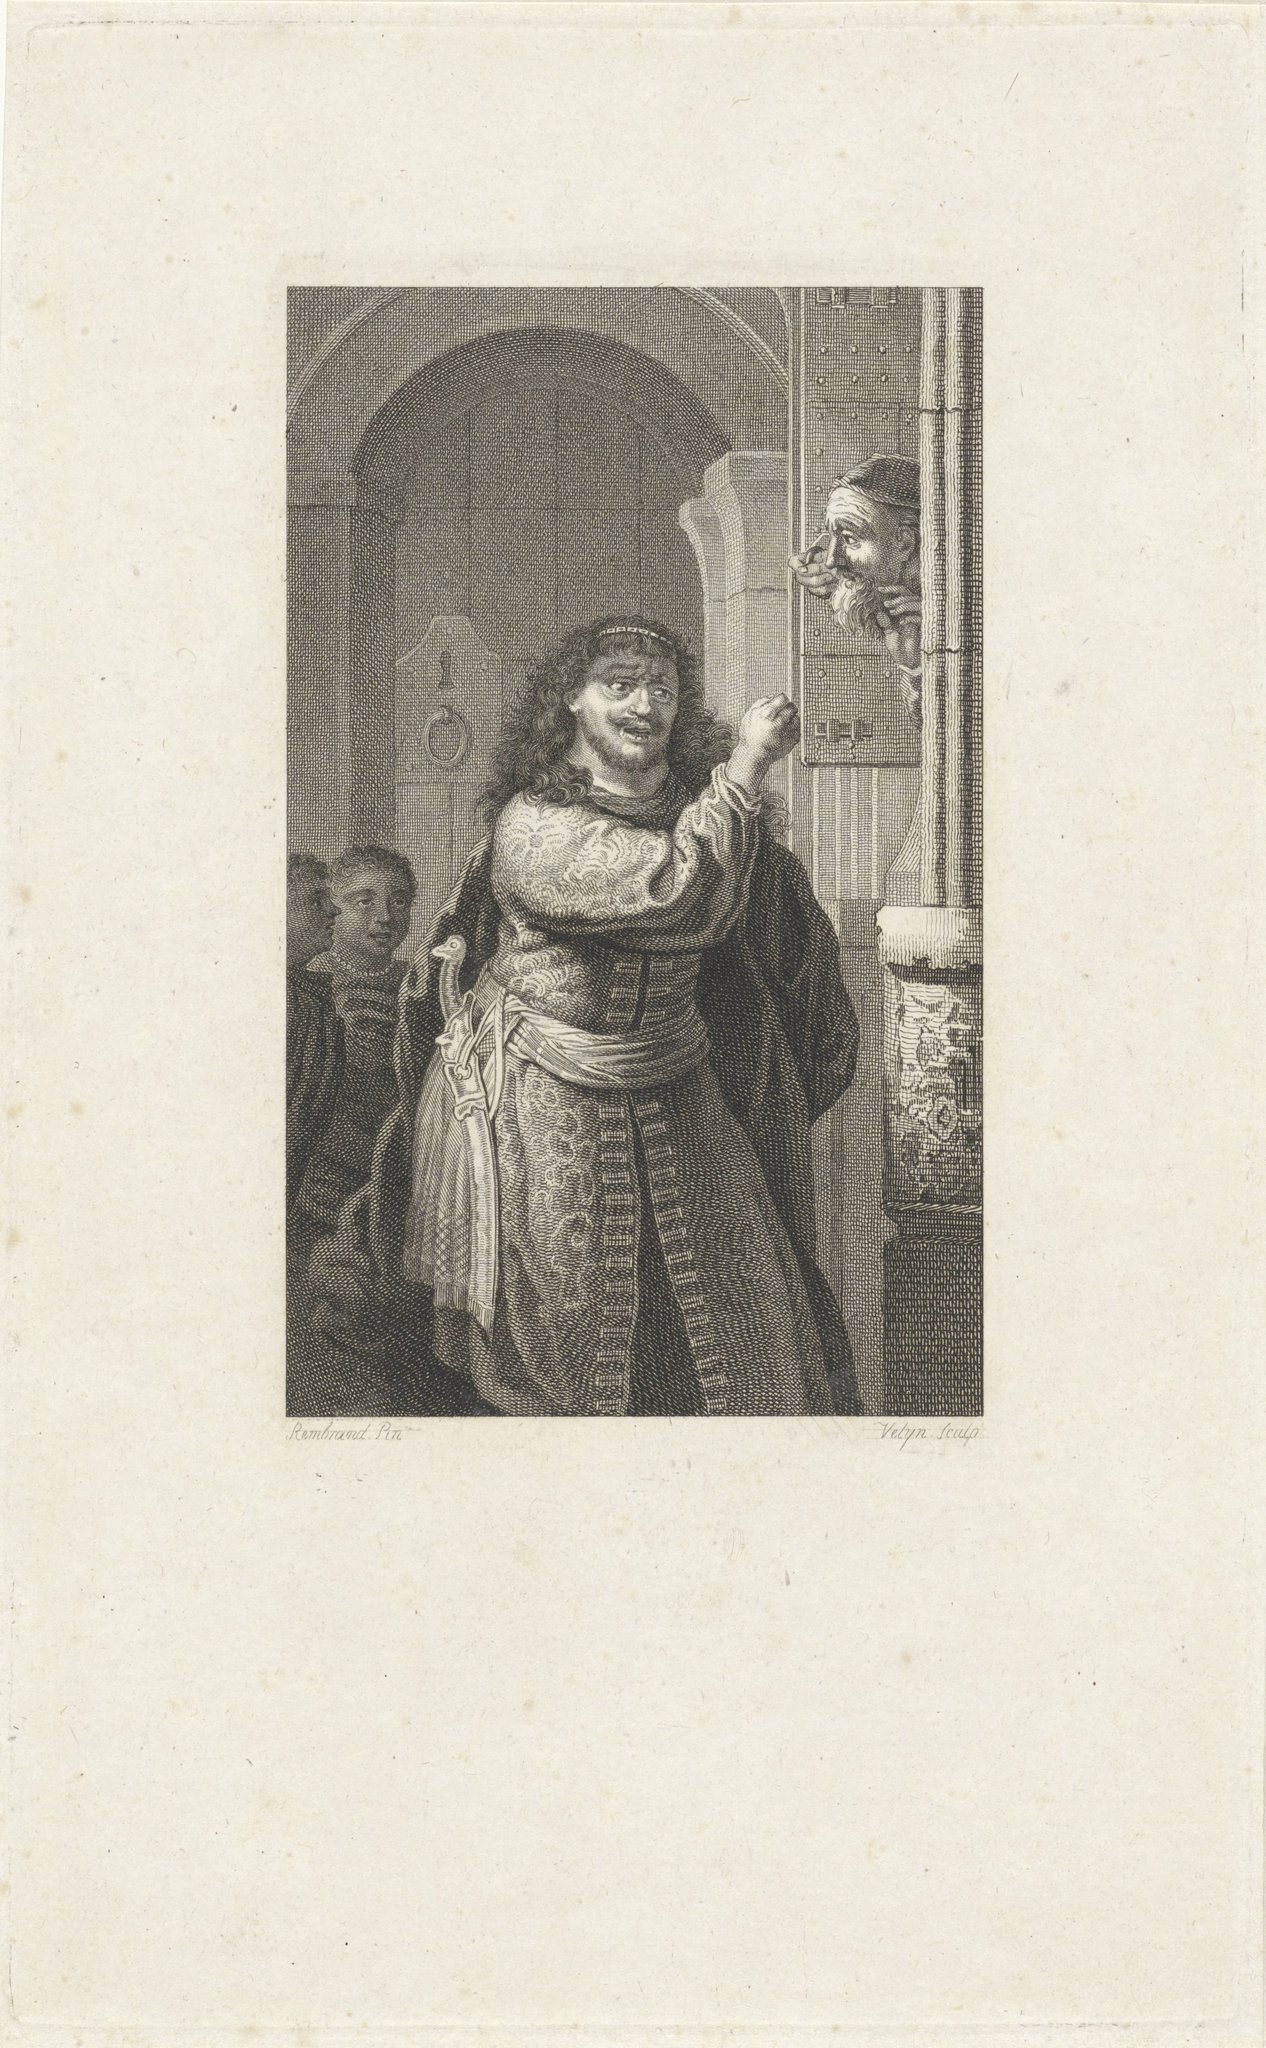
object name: print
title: Simson zijn schoonvader bedreigend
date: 1819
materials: paper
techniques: etching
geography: netherlands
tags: samson goes with a kid to his wife and is refused entry by her father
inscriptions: collector's mark: Lugt 2228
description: Sinds de 18e eeuw en tot ver in de 19e eeuw was de titel van het schilderij: Adolf van Gelder, zijn gevangen vader bespottend. Nu bekend als: Samson zijn schoonvader bedreigend. Latere staat van de prent volgens Frederik Muller gebruikt als illustratie voor: v. Kampen, Vaderl. Geschied., 1e druk v. 1819. Genummerd op de prent: pl. 1. (Dit werk heb ik niet kunnen achterhalen, DH).